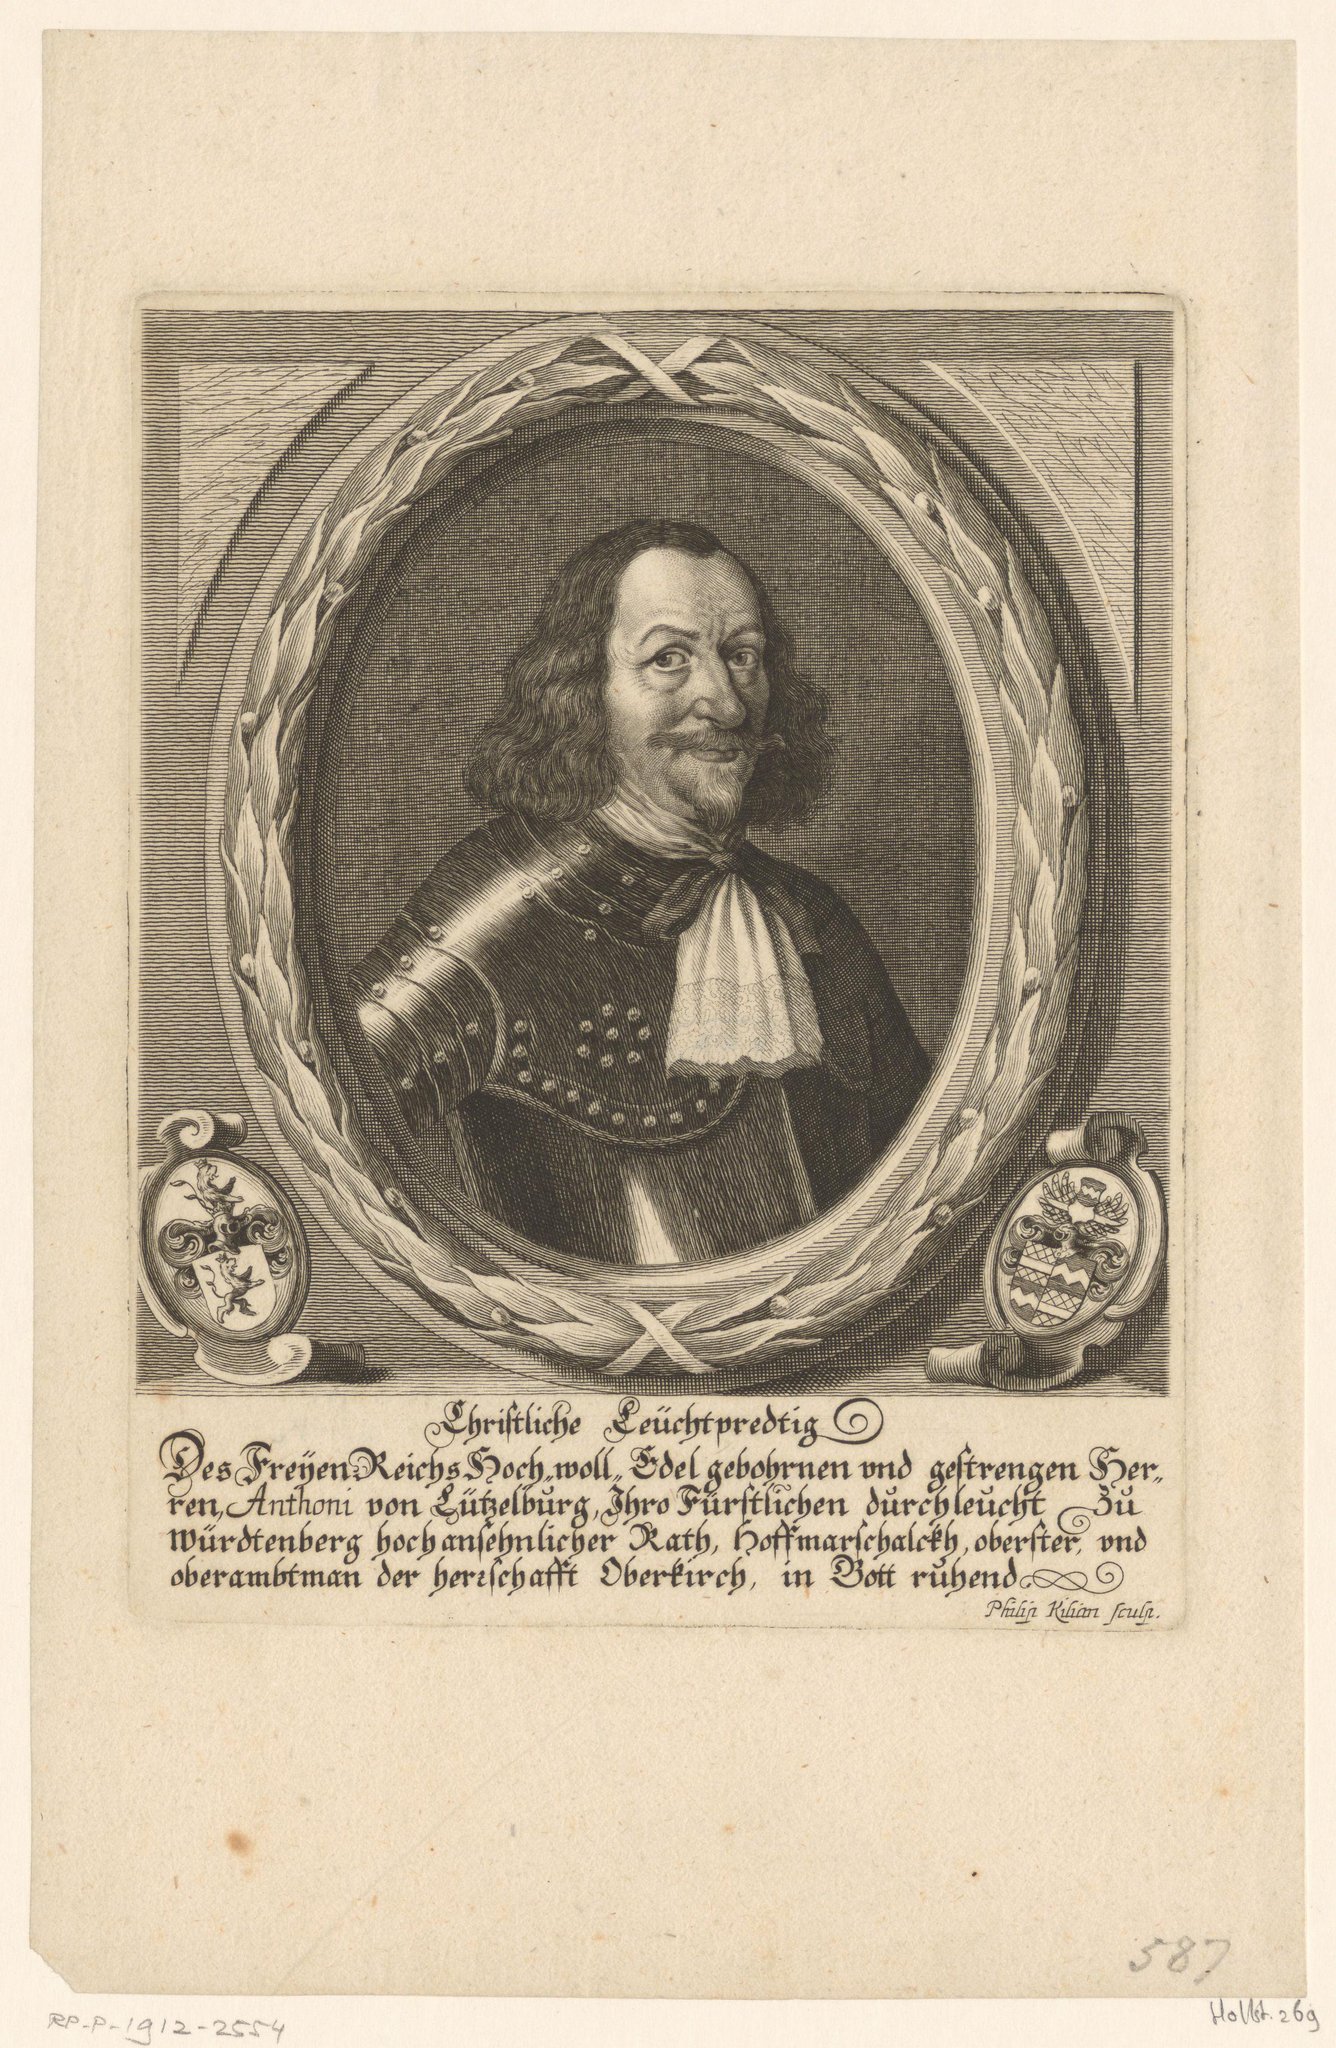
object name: print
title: Portret van Anton van Lützelburg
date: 1638-1693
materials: paper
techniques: engraving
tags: city council, historical persons, counsellor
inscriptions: collector's mark: Lugt 2228